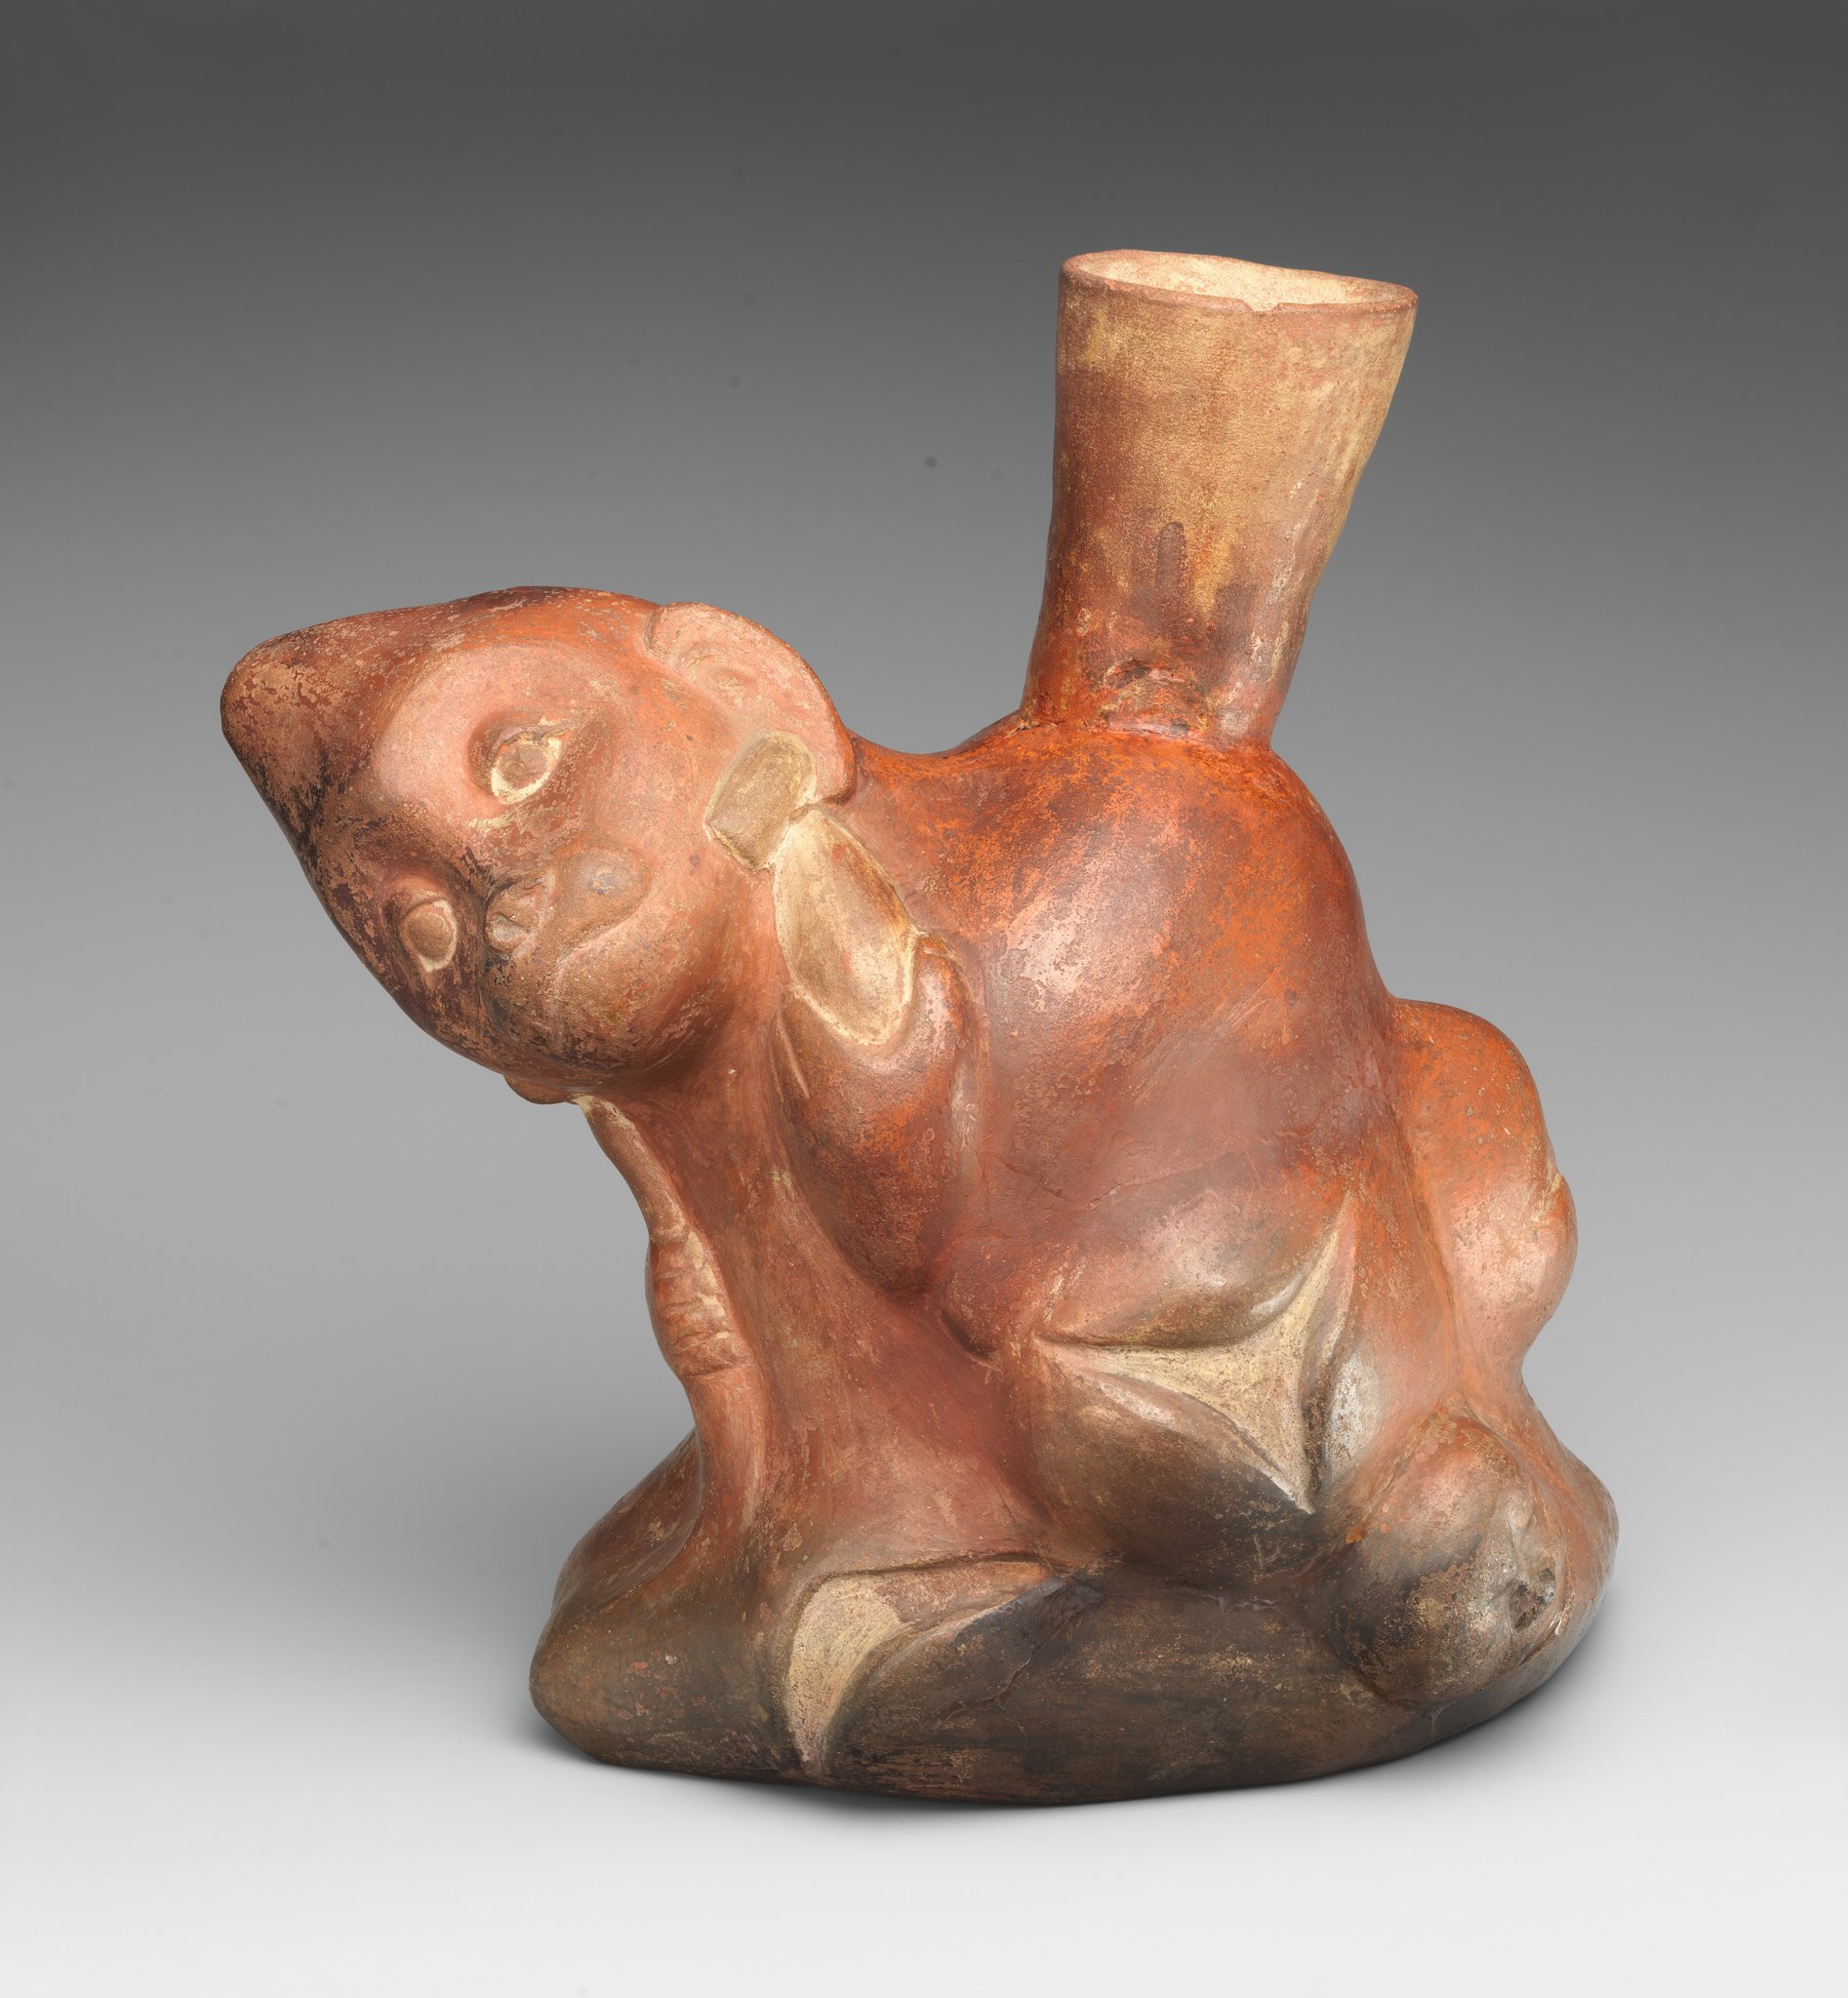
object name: vessel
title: Tuber-inspired stirrup-spout bottle with monkeys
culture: moche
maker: moche artist(s)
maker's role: artist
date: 200-800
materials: ceramic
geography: peru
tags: monkeys